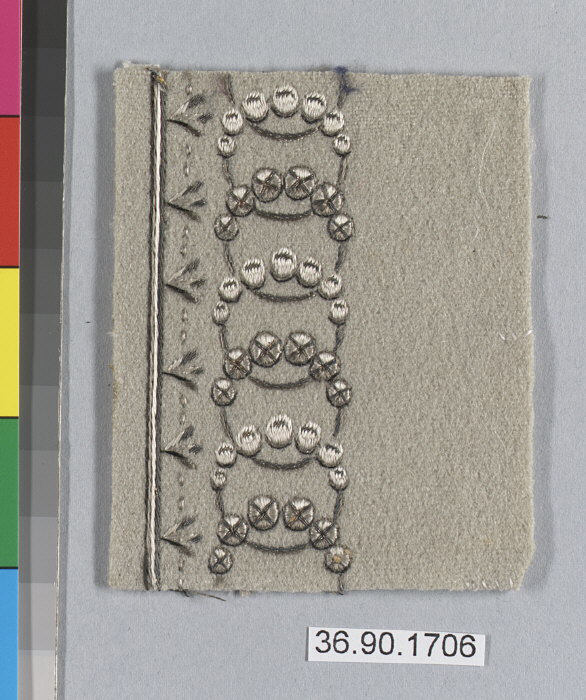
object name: sample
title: Embroidery sample for a man’s suit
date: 1785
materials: felt, metal thread, silk